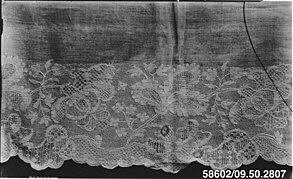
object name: kerchief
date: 1701-1800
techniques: embroidery